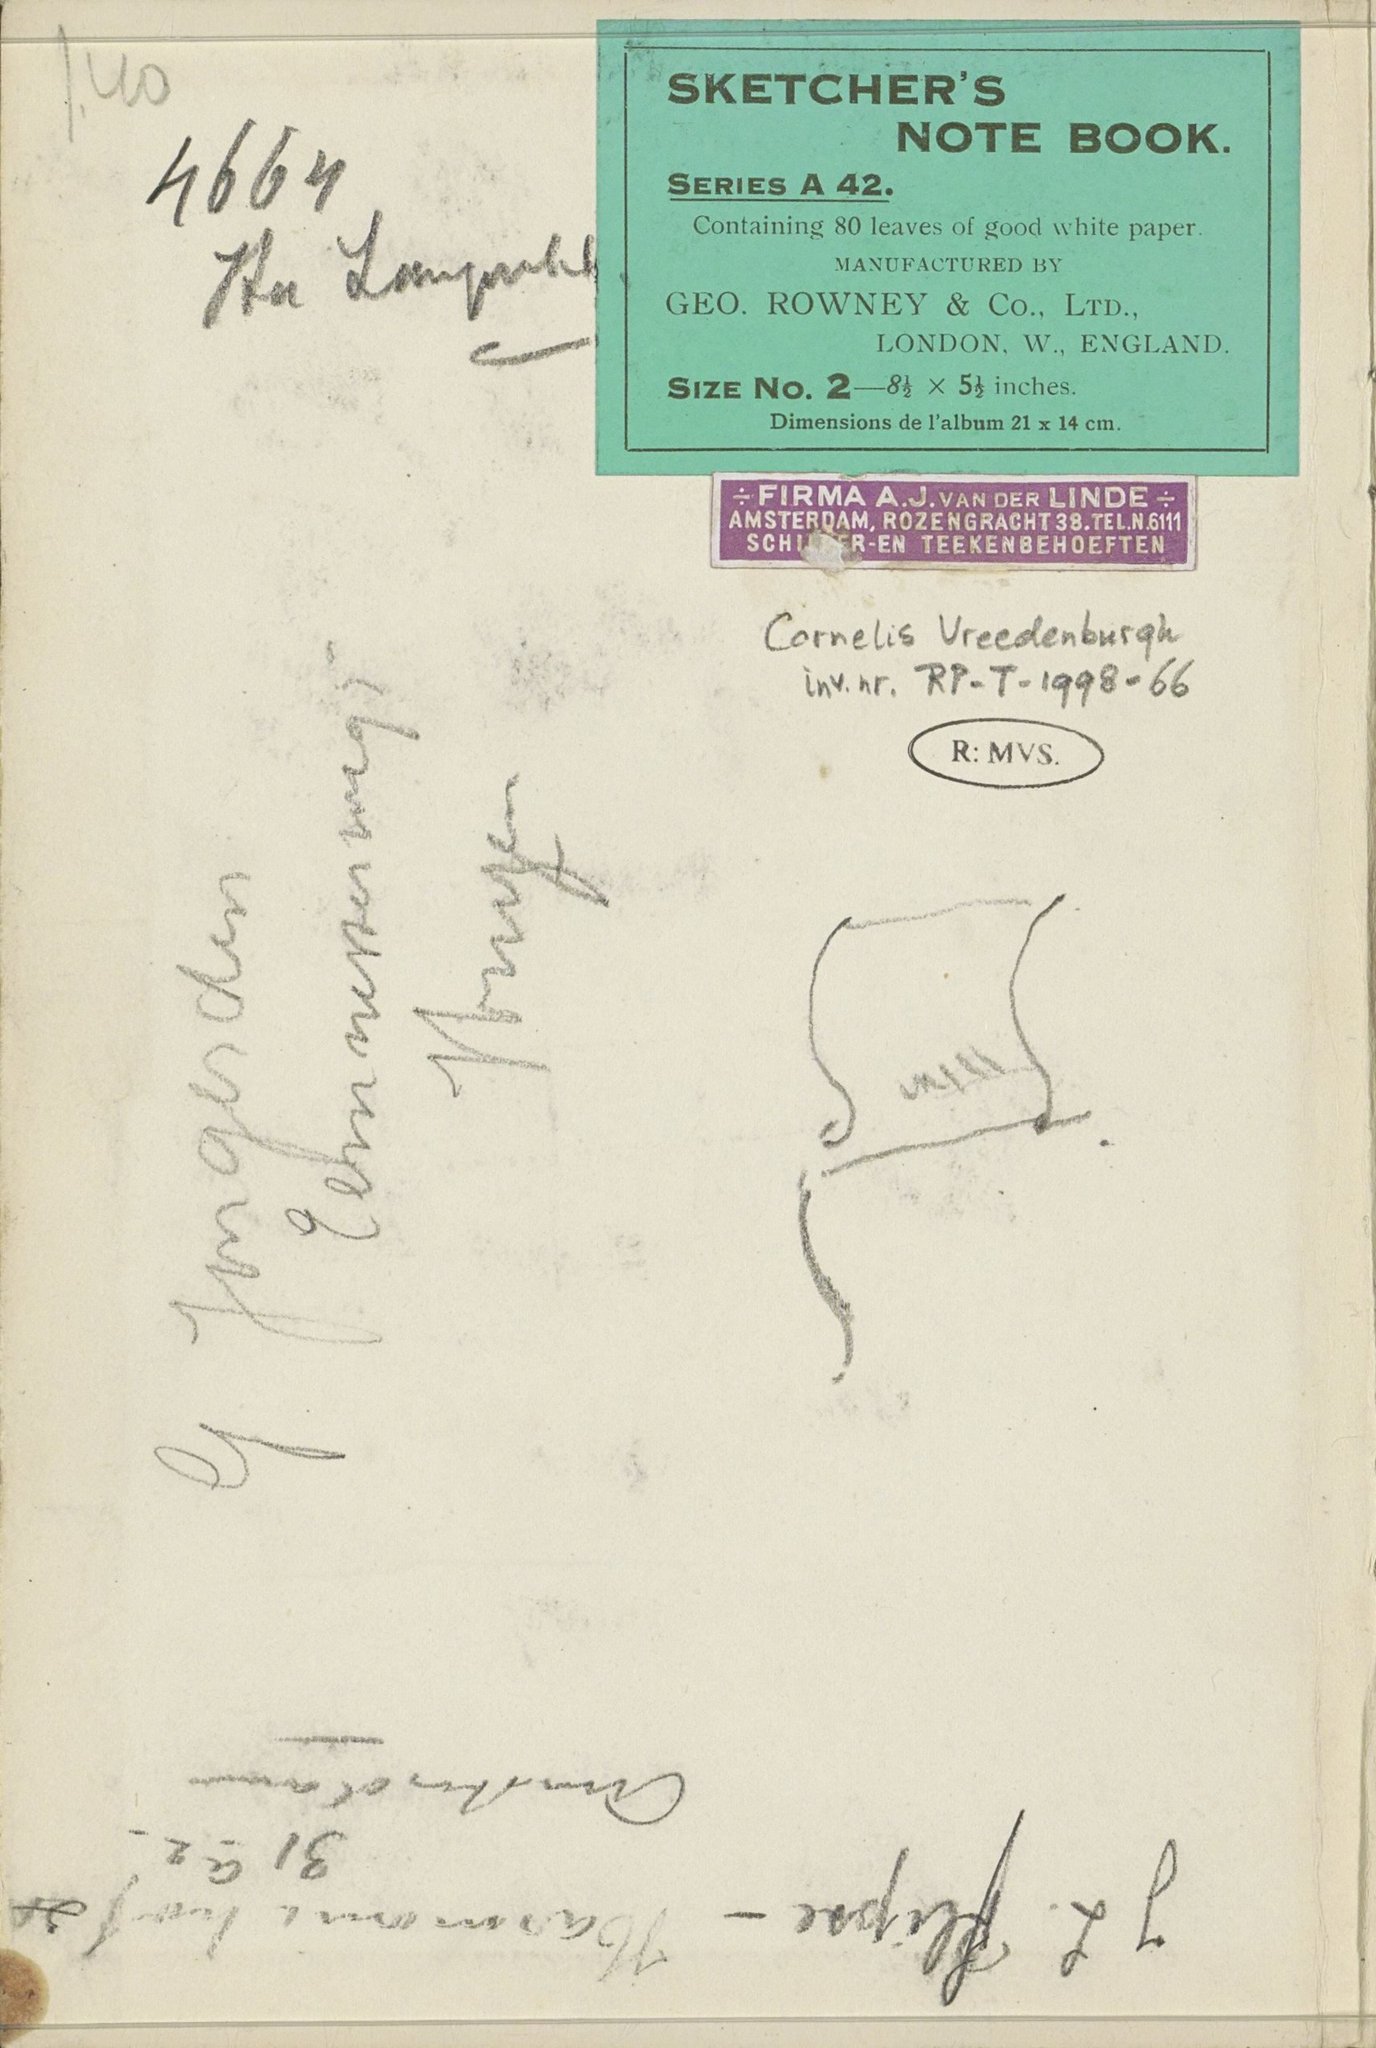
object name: sketchbook leaf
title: Vlag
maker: cornelis vreedenburgh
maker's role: draughtsman, print maker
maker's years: 1880-1946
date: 1890-1946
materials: paper, pencil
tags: flags (~ signalling)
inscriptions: factory mark: ‘SKETCHER'S/ NOTE BOOK/ SERIES A 42/ containing 80 leaves of good white paper./ MANUFACTURED BY/ GEO. ROWNEY & CO., LONDON, W., ENGLAND/ SIZE No. 2- 8 1/2 x 5 1/2 inches./ Dimensions de l'album 21 x 14 cm.’, collector's mark: Lugt 2228a, annotation: ‘1.40/ 4664/ [...]u Lamp[...]/ G Jongerden/ Eemnesserweg 5/ Huizen/ J.L. flipse - Harmoniehof/ 31a2/ Amsterdam’, retailer's mark: ‘FIRMA A.J. van der LINDE/ AMSTERDAM, ROZENGRACHT 38, TEL.N 6111/ SCHILDER-EN TEEKENBEHOEFTEN’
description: Voorste schutblad uit een schetsboek met uit 75 bladen.